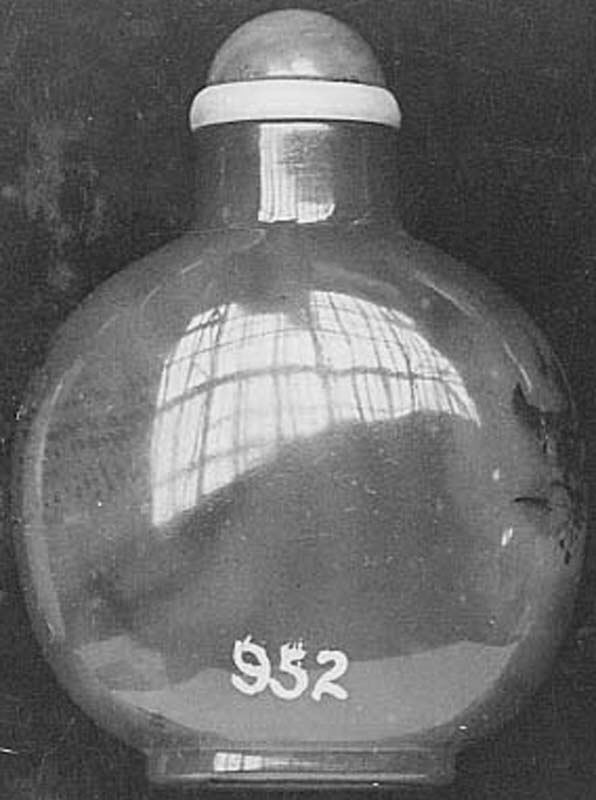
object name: snuff bottle with stopper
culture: chinese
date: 1701-1900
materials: stone